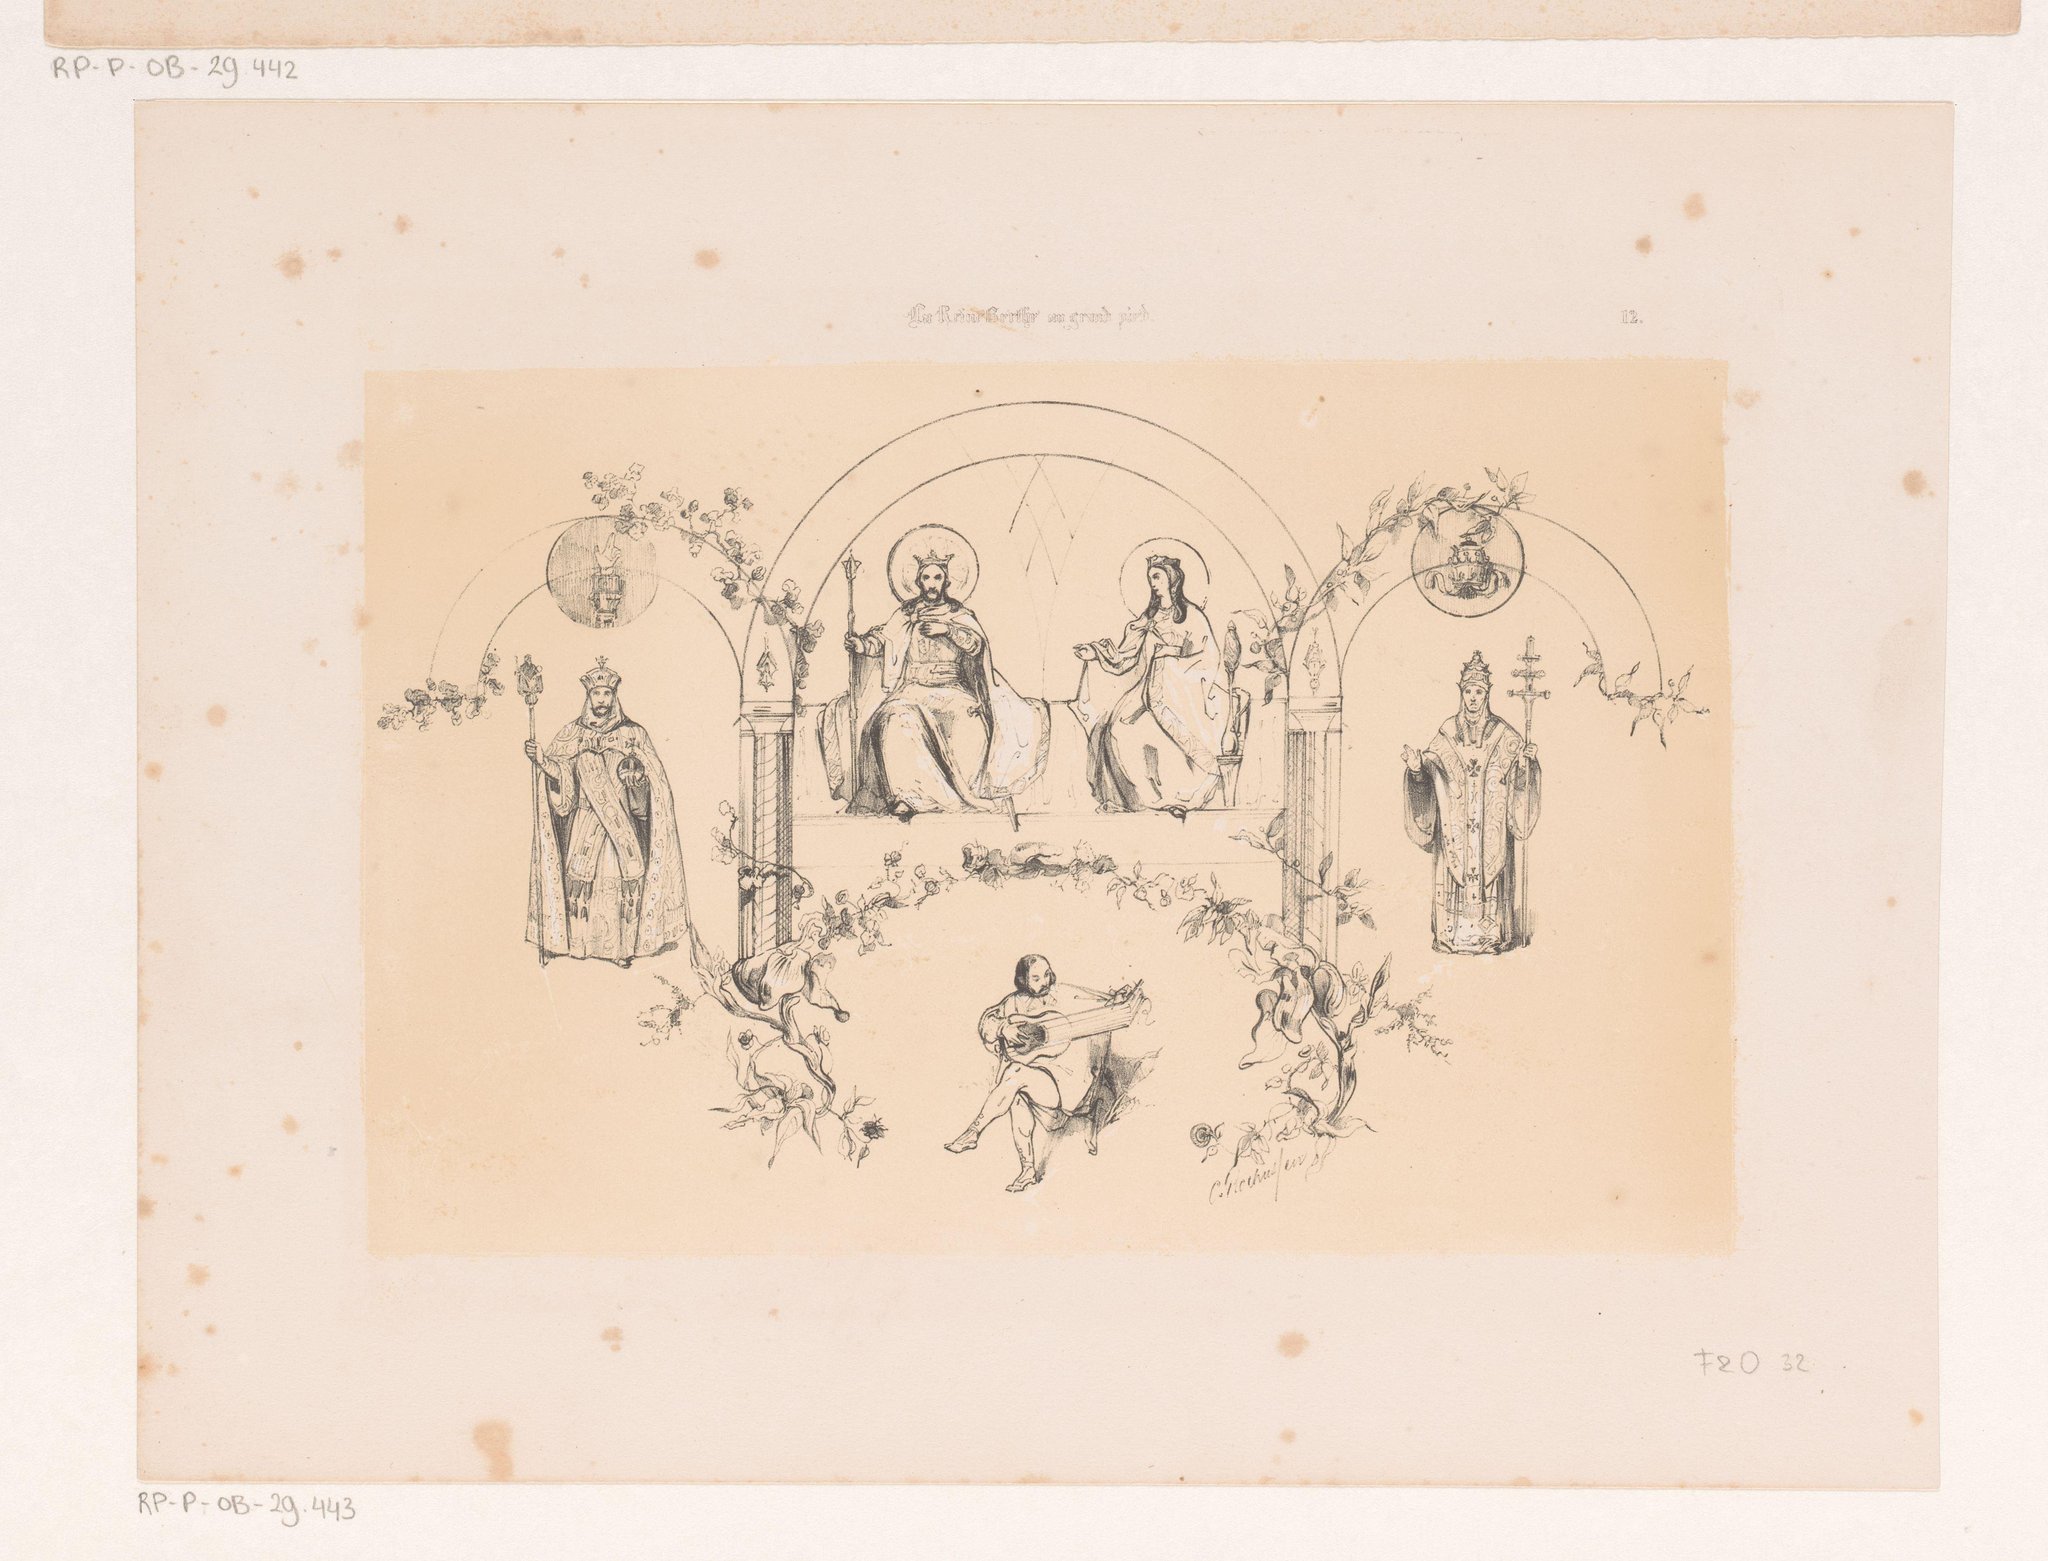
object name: book illustration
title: Tronende koning en koningin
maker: charles rochussen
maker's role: draughtsman, painter, print maker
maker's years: 1814-1894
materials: paper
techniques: tone lithography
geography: the hague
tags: queen, king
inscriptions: collector's mark: Lugt 2228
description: Een tronende koning en koningin zitten onder een rondboog. Links en rechts staan een geestelijke. Aan de onderzijde een luitspelende man.